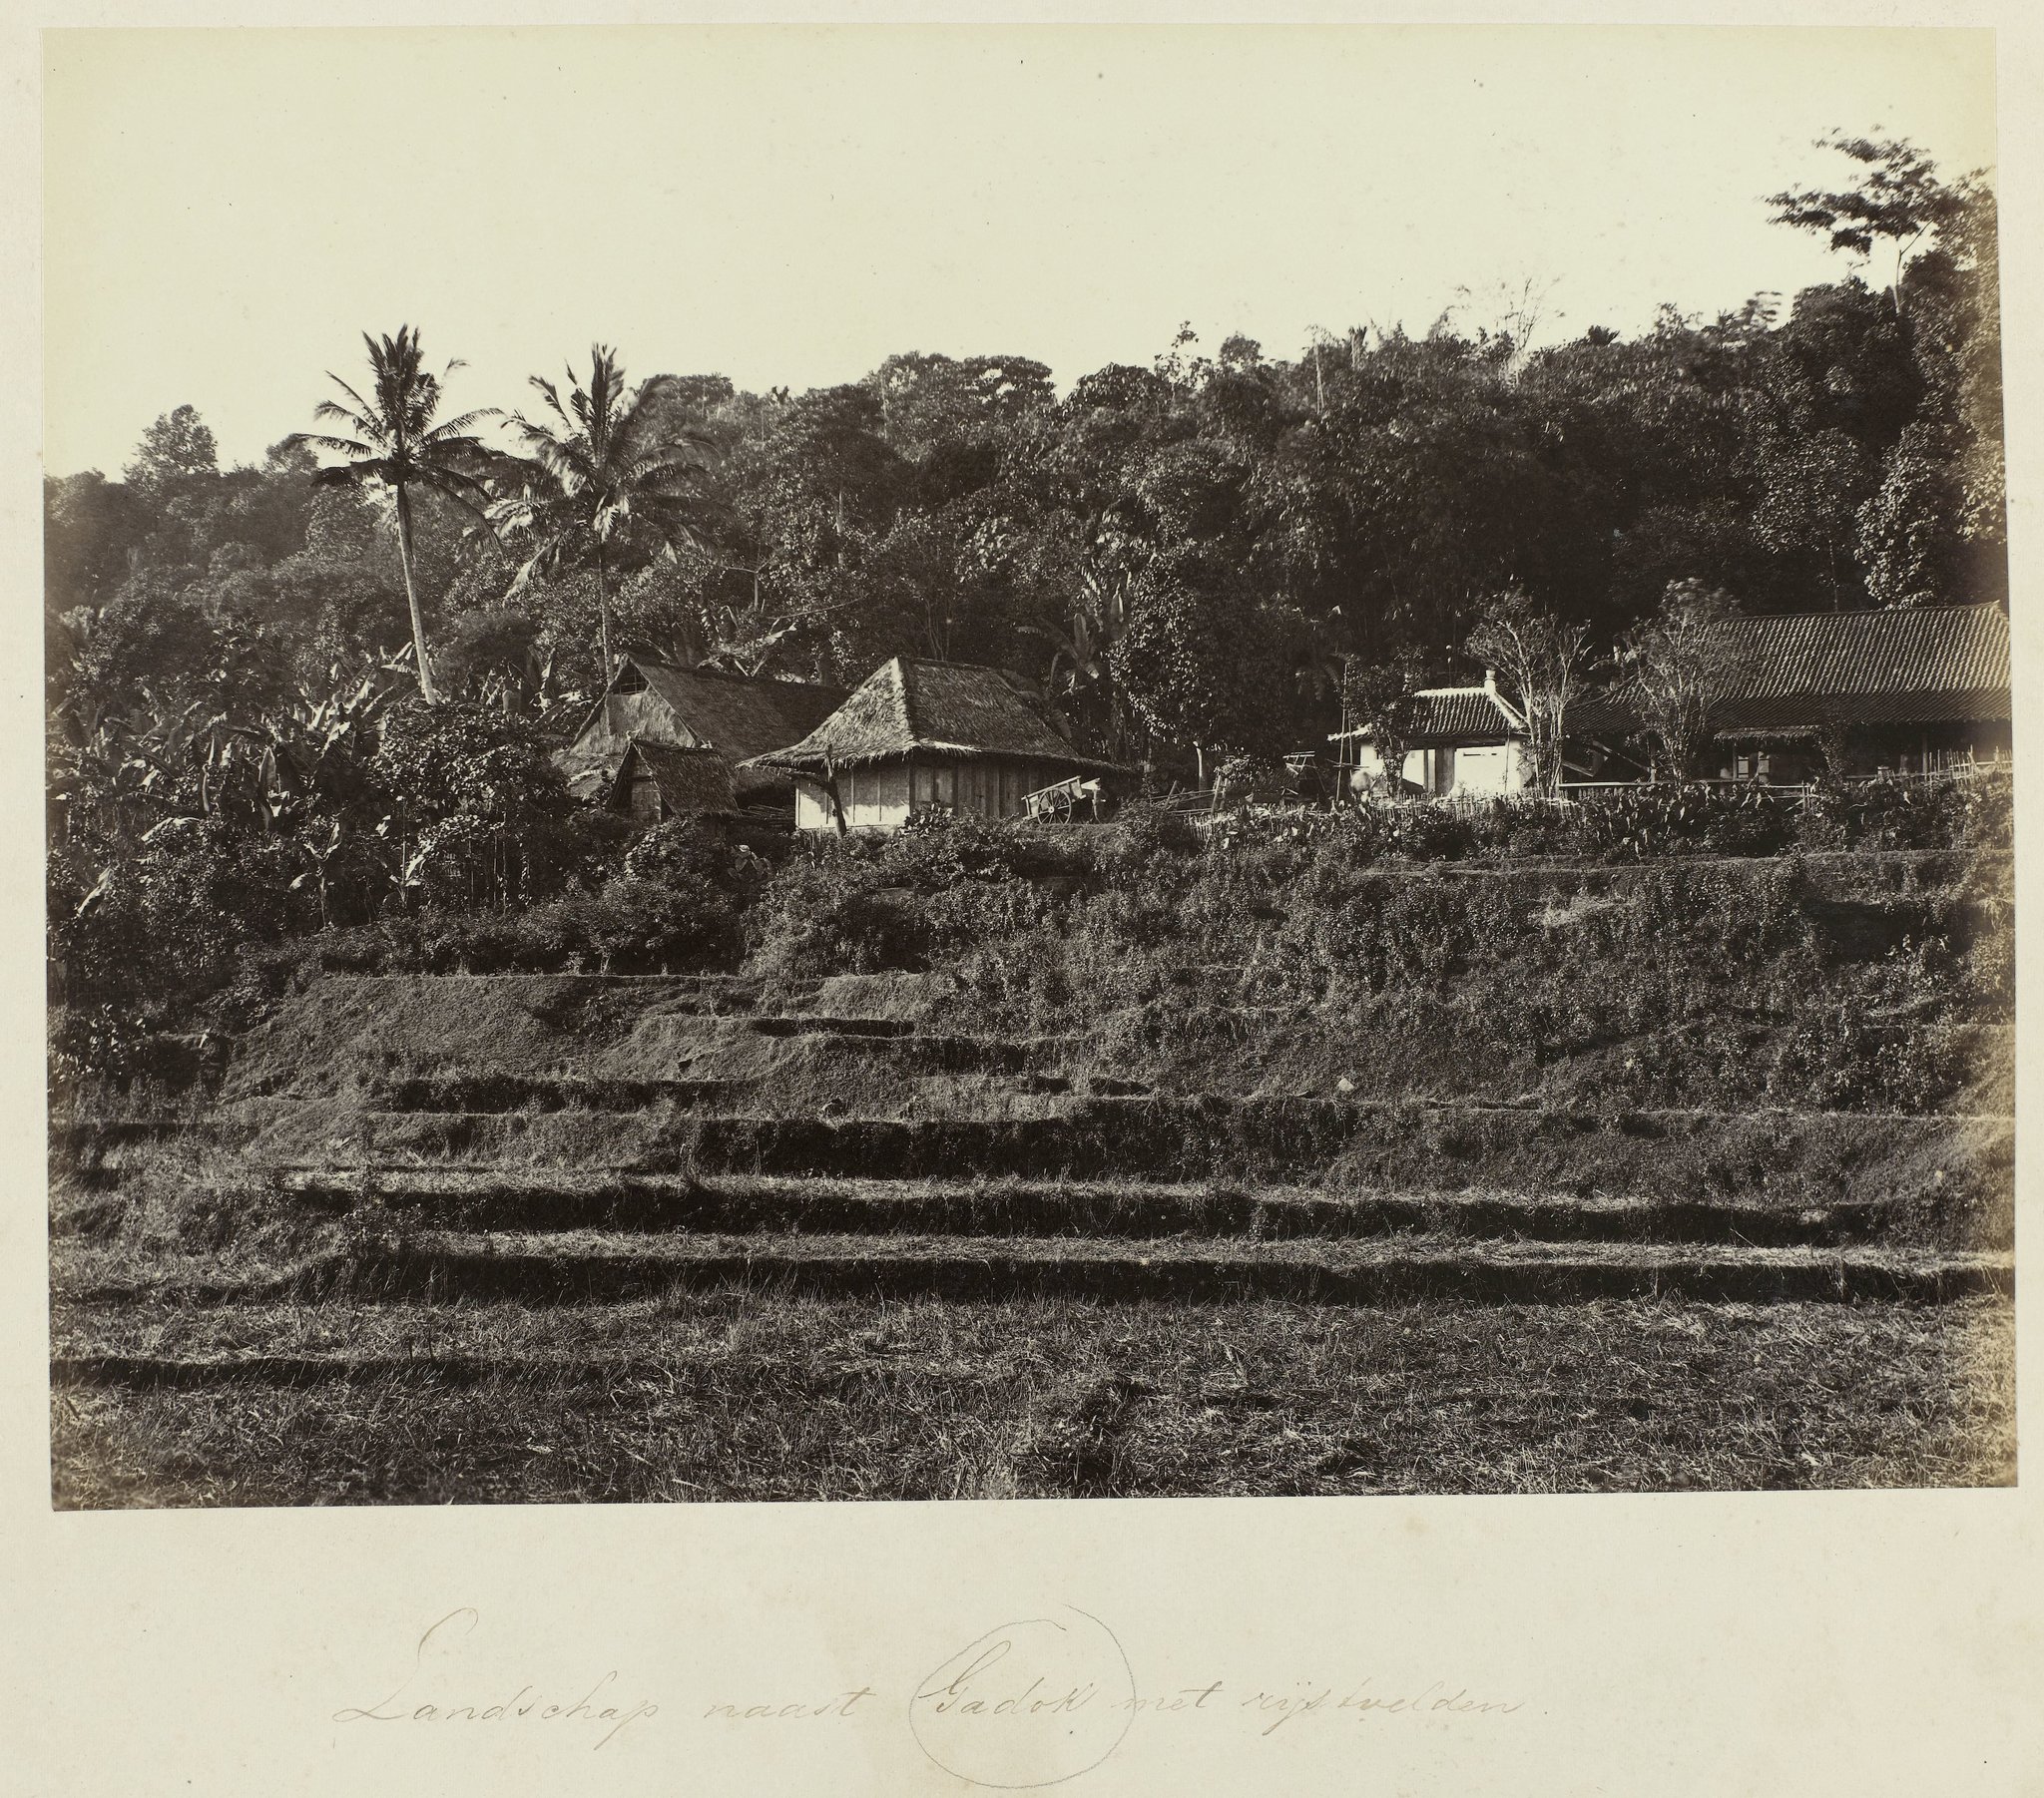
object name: photograph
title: Landschap naast Gadok met rijstvelden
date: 1863-1869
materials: photographic support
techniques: albumen print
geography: buitenzorg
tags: sawahs, rice paddies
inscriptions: inscription: ‘Landschap naast Gadok met rijstvelden’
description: Sawa's bij Gadog, in de omgeving van Buitenzorg. Onderdeel van het groene fotoalbum met foto's van Java, uit het bezit van apotheker Specht-Grijp, die in 1865 vanuit Batavia naar Nederland terugkeerde.